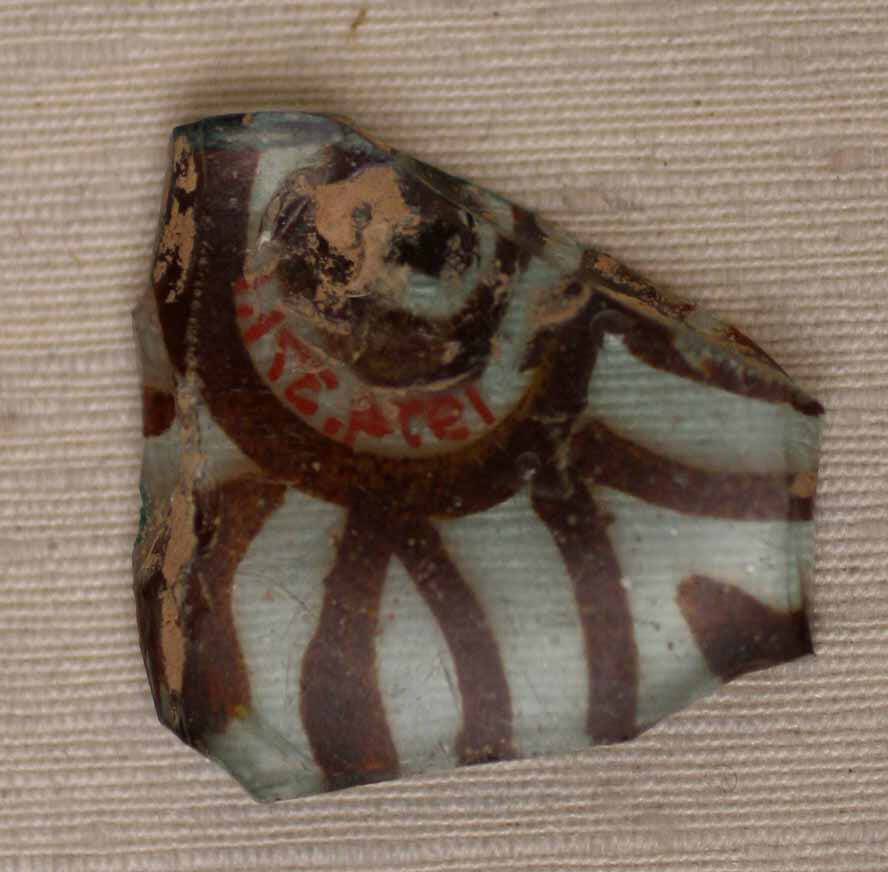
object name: fragment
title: Glass Fragment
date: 801-900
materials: glass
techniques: luster painting, stain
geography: egypt or iraq